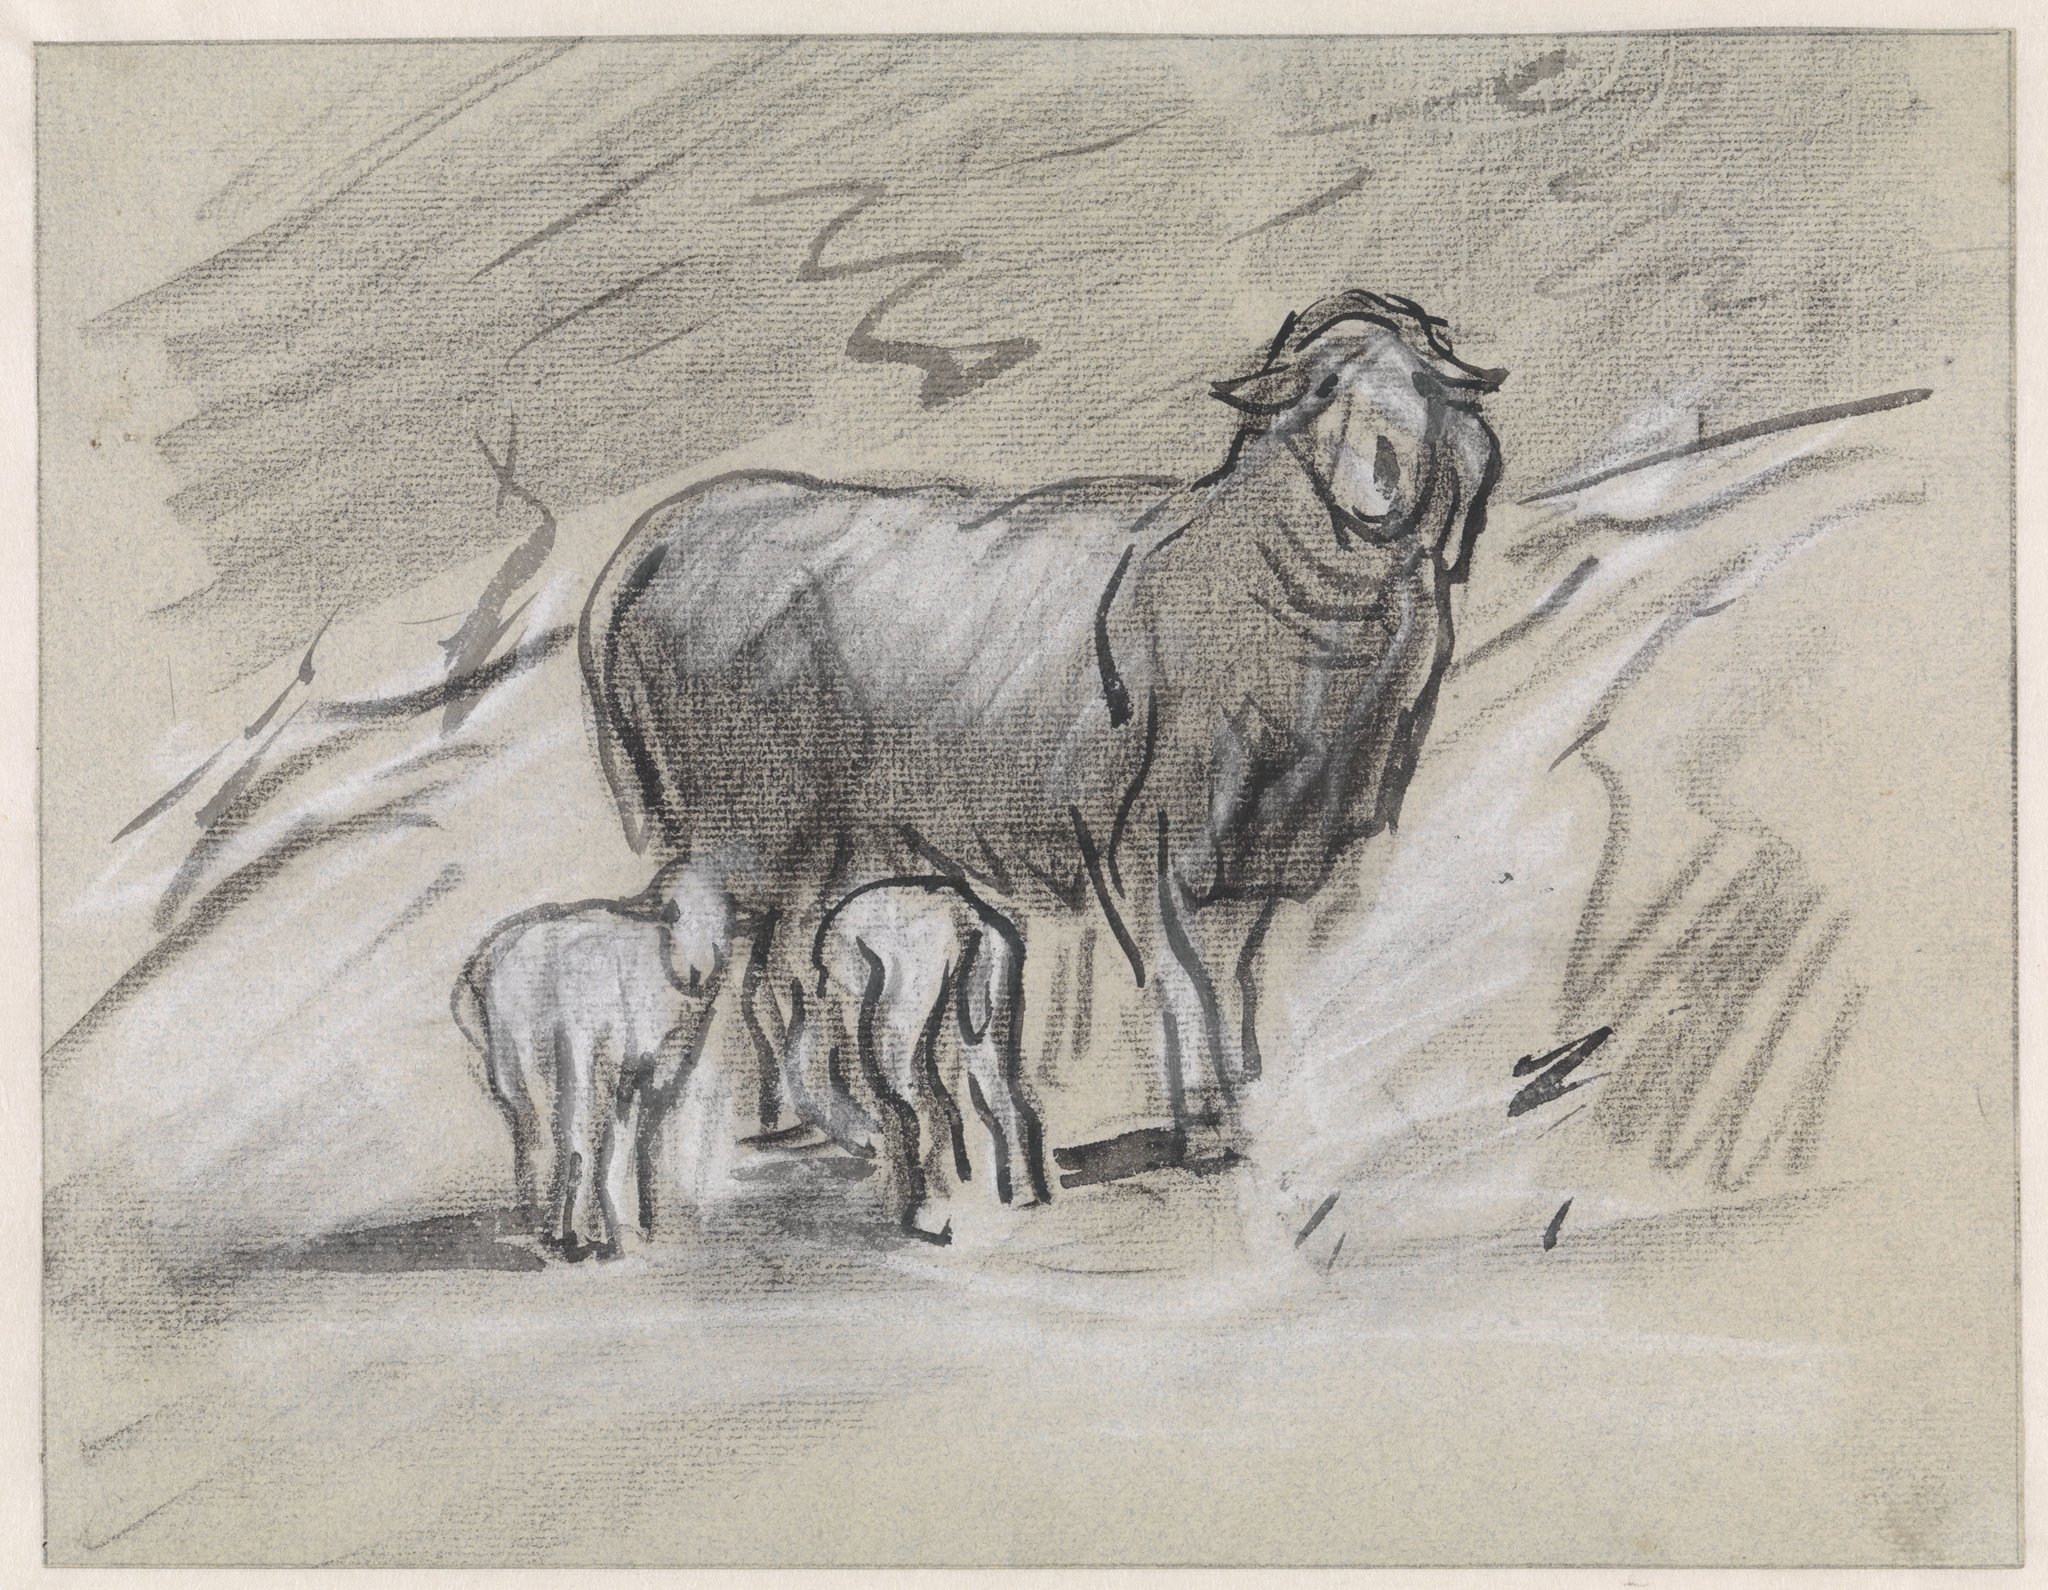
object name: drawing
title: Schaap met twee lammetjes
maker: jan van essen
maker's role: draughtsman, print maker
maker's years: 1854-1936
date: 1864-1936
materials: chalk, paper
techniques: brush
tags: sheep